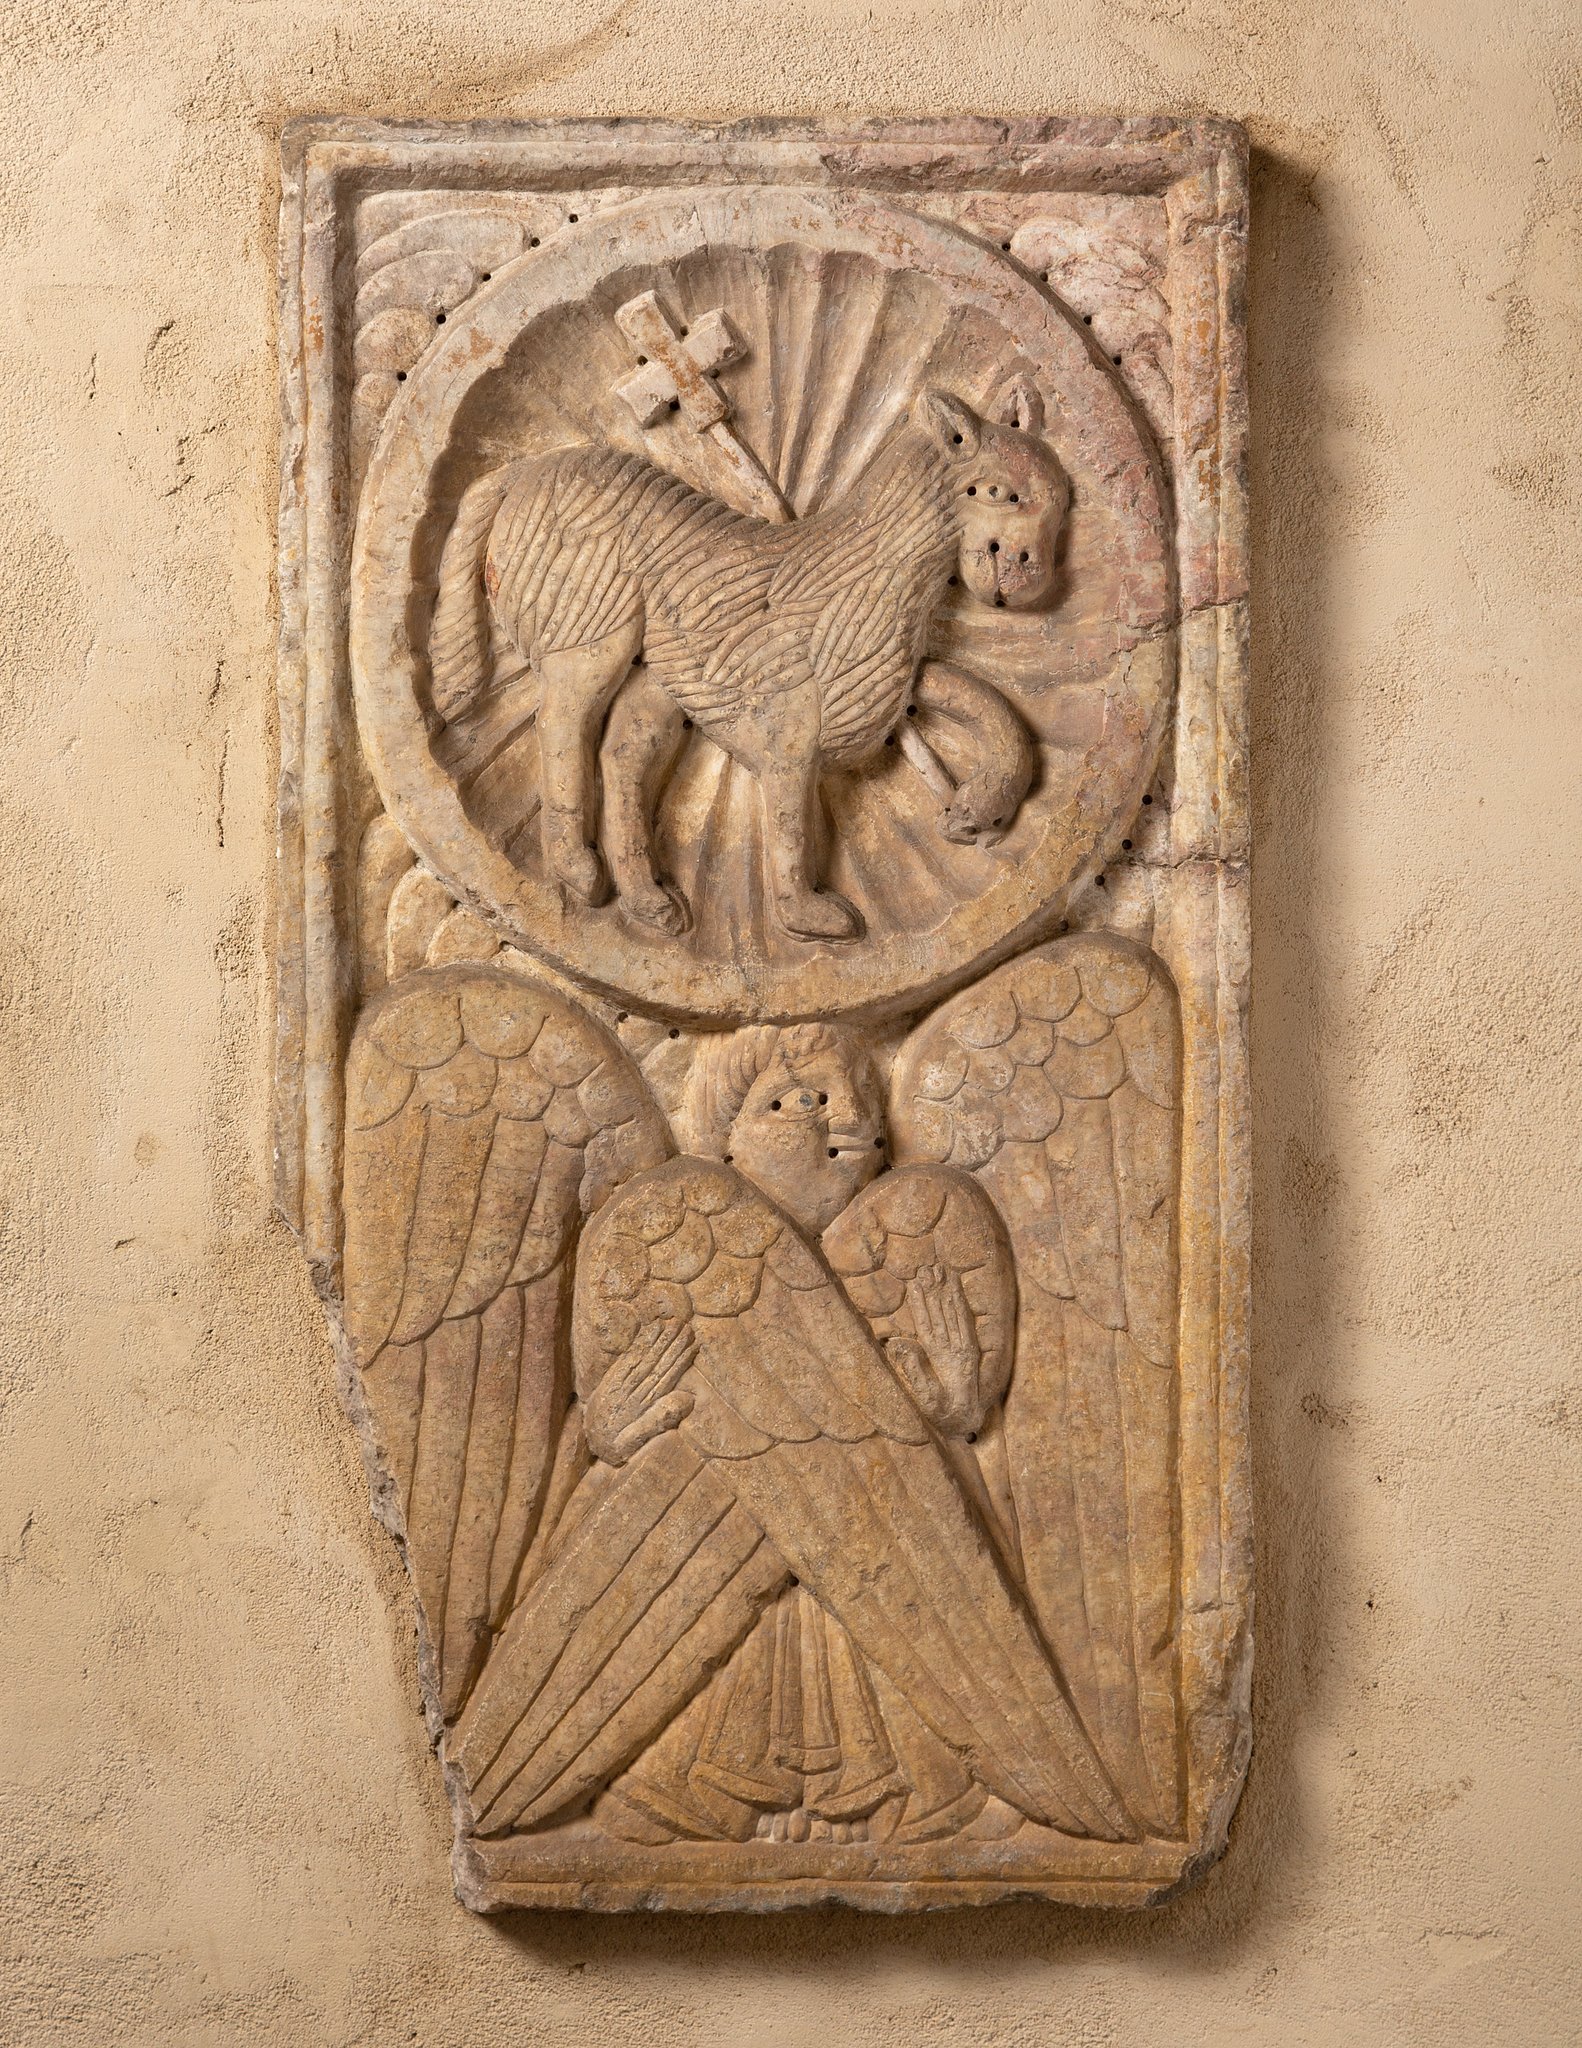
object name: relief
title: Relief of Agnus Dei and Cherub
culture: catalan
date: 1140-1150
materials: marble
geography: france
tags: putti,lambs